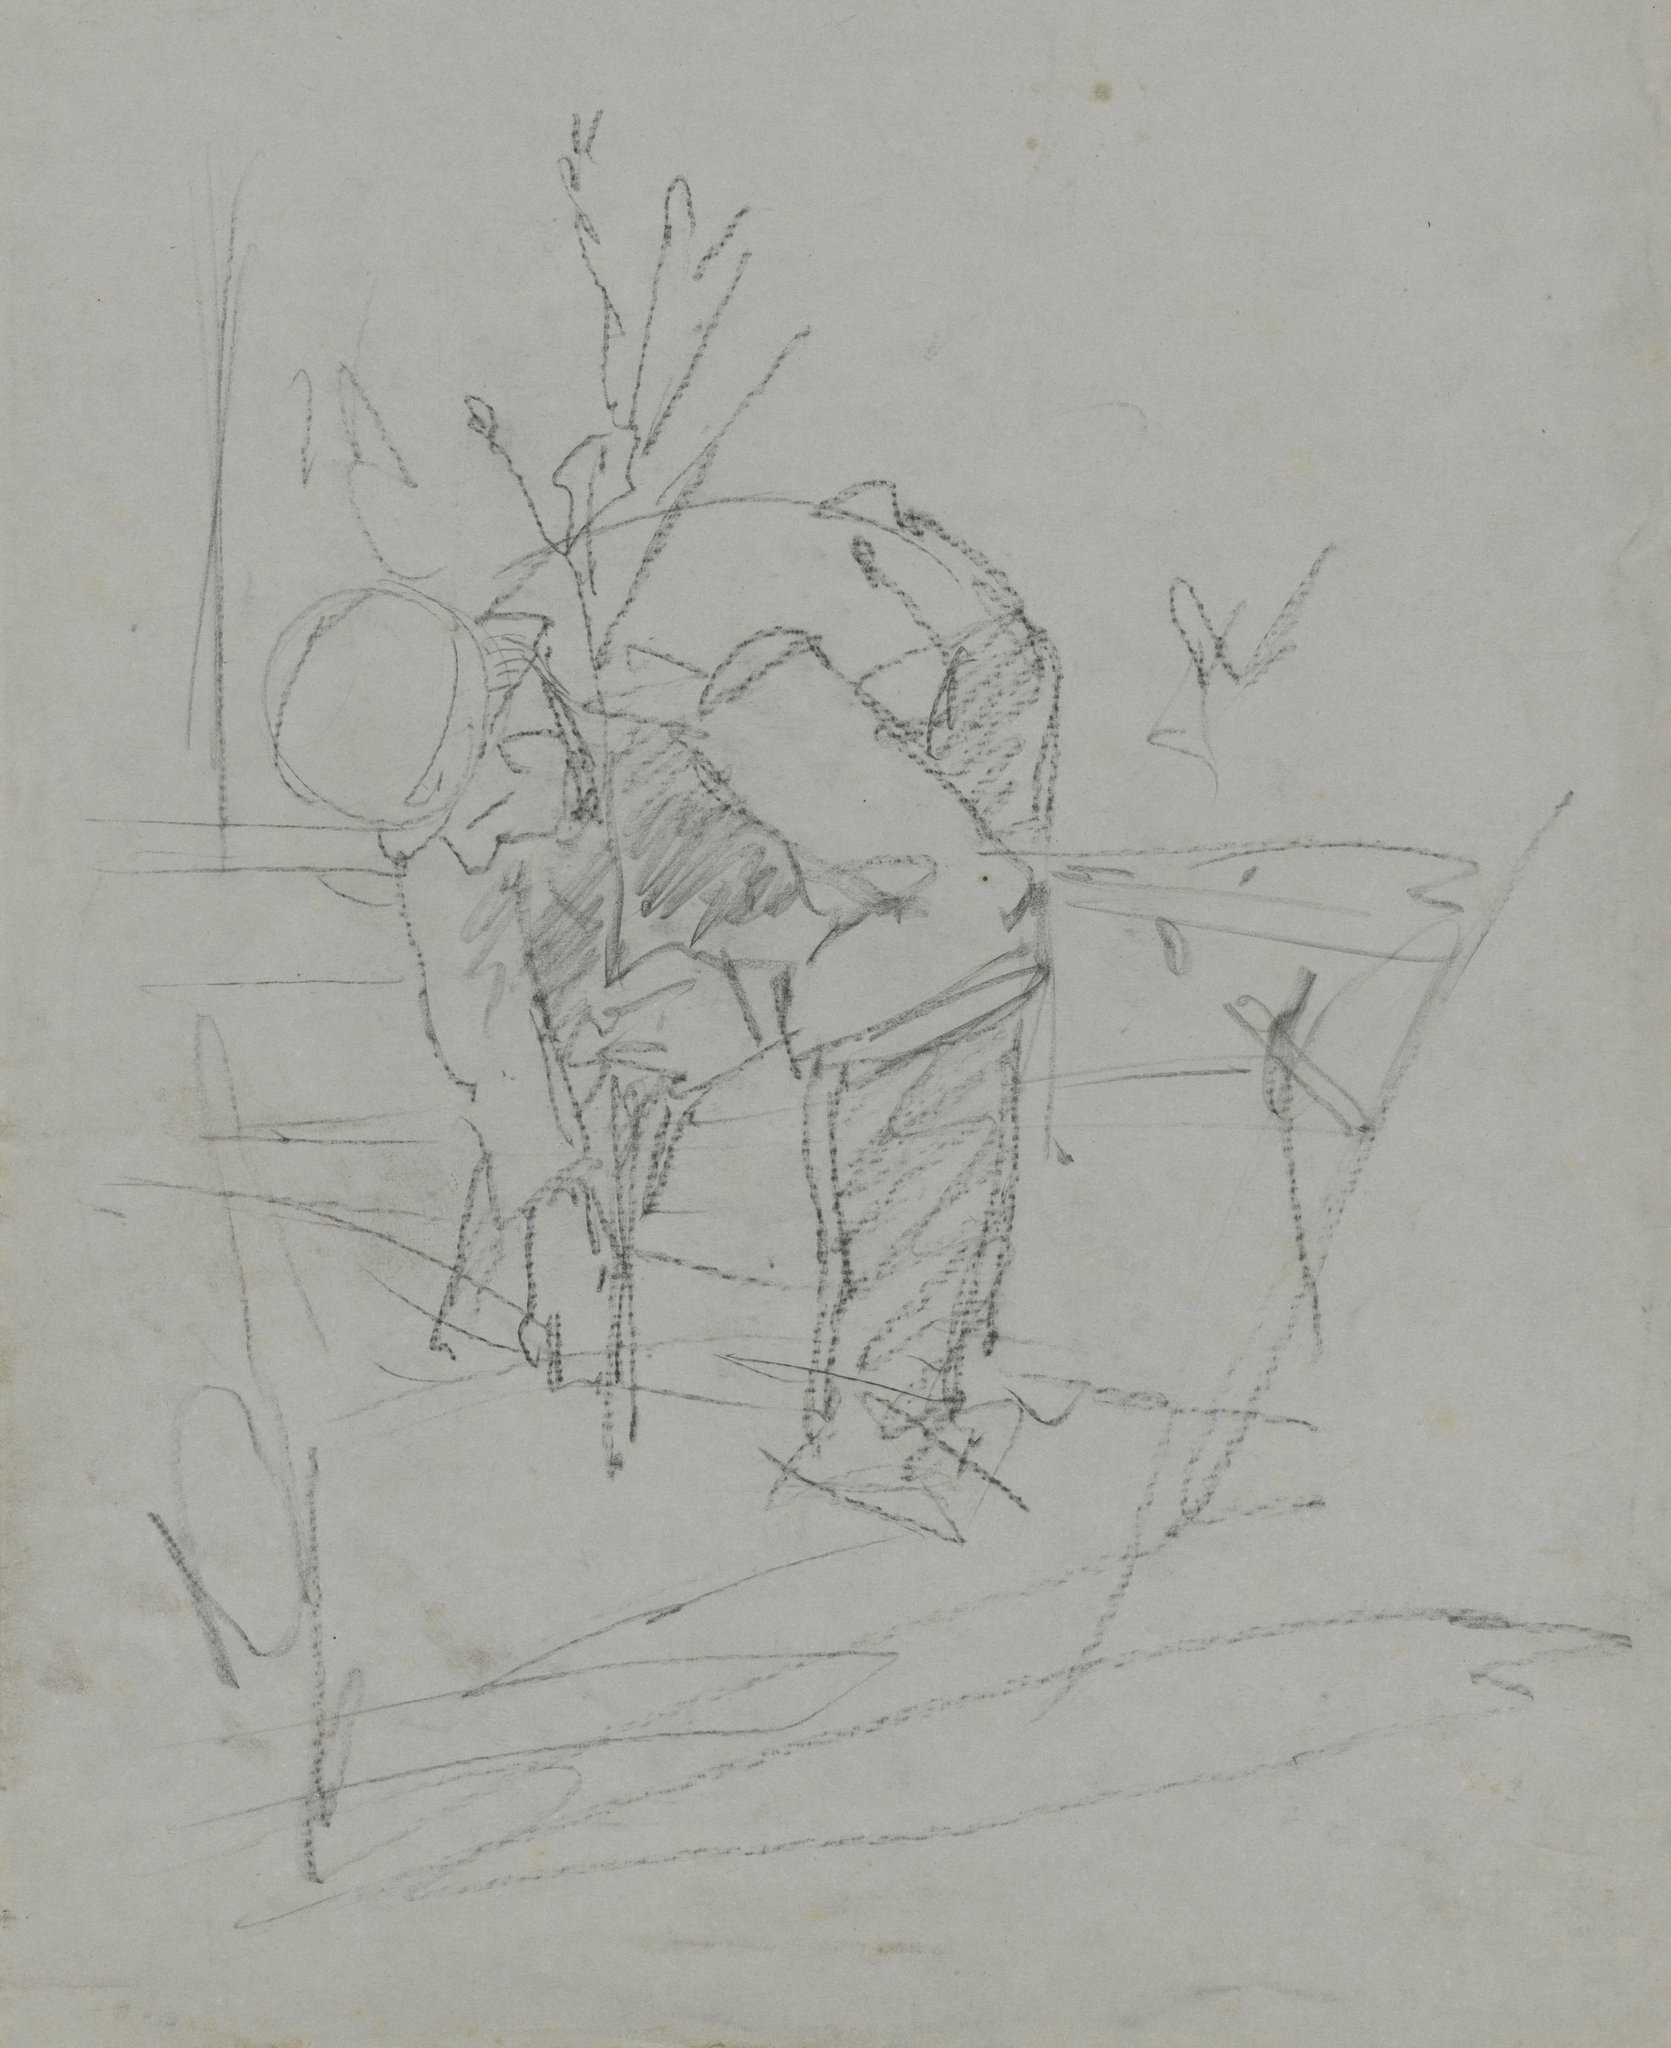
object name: drawing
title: Boomplanter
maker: adolf le comte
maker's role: draughtsman, painter, print maker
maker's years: 1850-1921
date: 1860-1921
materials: chalk, paper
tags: trees, arboriculture